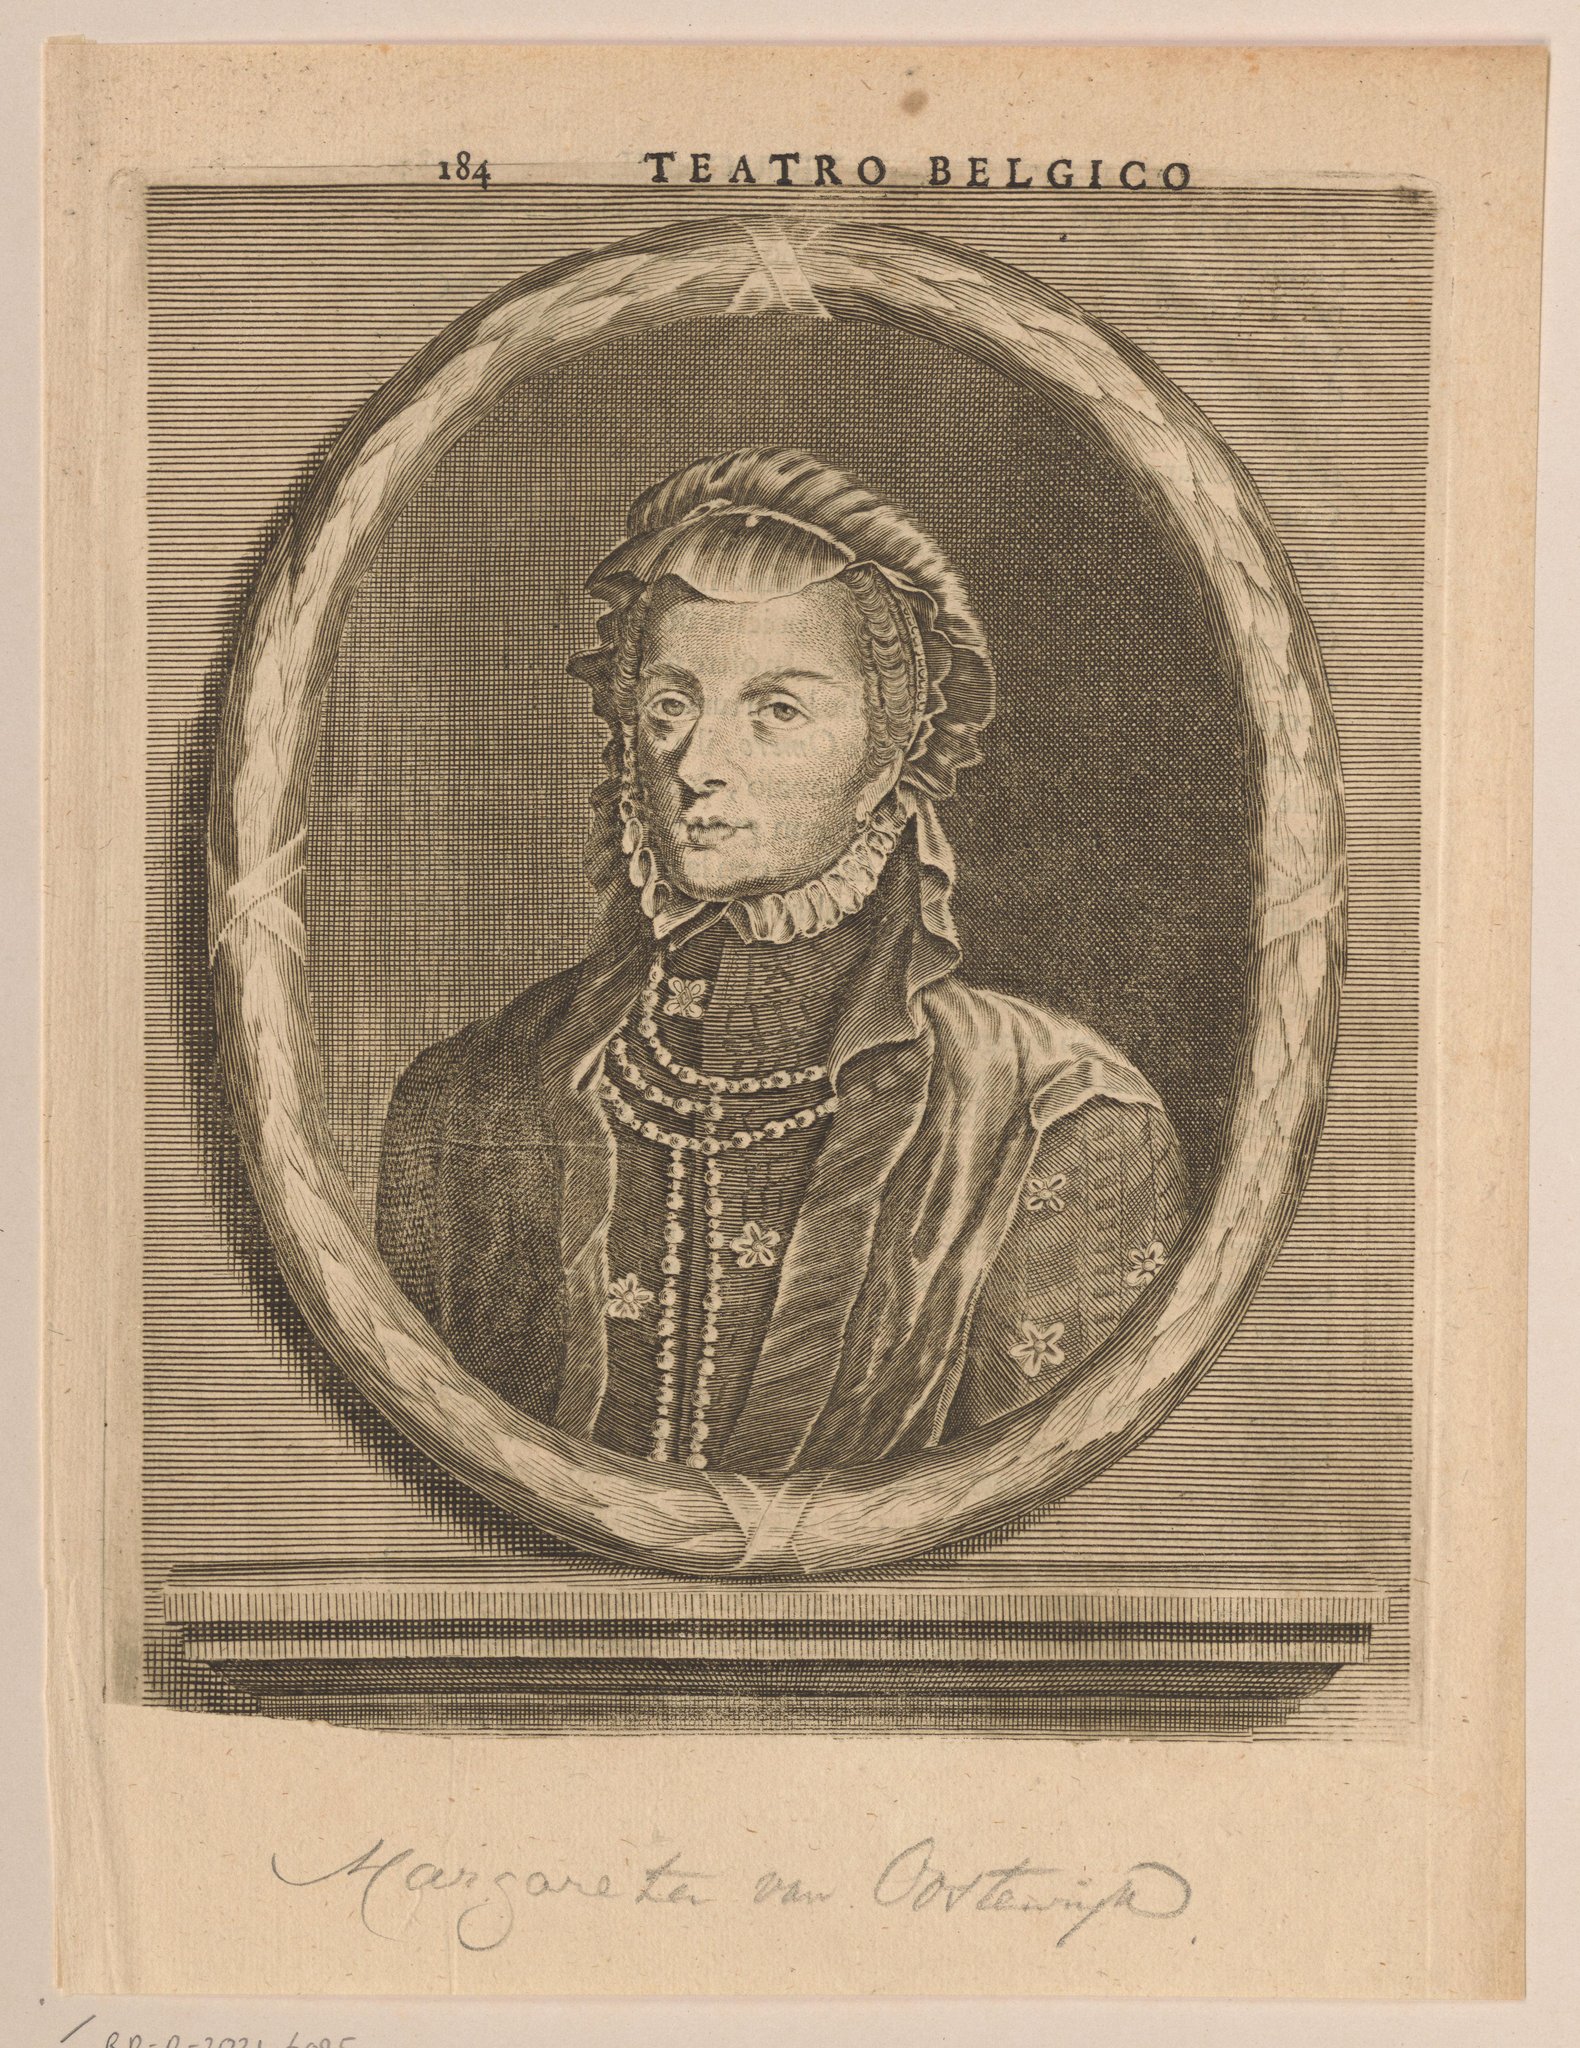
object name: print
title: Portret van Margaretha van Parma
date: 1690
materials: paper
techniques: engraving, letterpress printing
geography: northern netherlands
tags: historical persons - bb - woman, ornament ~ medallion, regent, substitute ruler; viceroy - bb - female ruler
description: Prent uit: Leti, Gregorio. Teatro Belgico, o verso ritratti historici, chronoligici, politici, e geografici (...). Amsterdam: Willem de Jonge, 1690, dl. 1, p. 184. Het onderste deel van de plaat is in deze uitgave afgedekt. De plaat is in zijn geheel in de eerste staat gebruikt in: Hooft, P.C. Nederlandsche Historien (...). Amsterdam: Johan van Someren et al., 1677. Een tweede bekende staat, met ander onderschrift, is gebruikt in: Bor, Pieter Christiaanszoon. Oorspronk, begin en vervolgh der Nederlandsche oorlogen (...). Amsterdam: weduwe Joannes van Someren et al., 1679, dl. 1. Een derde bekende staat, met 'Tom: I. No. 3', omlijst met een zwarte rand is gebruikt in 'Geschiedenissen der Vereenigde Nederlanden (...)', 1730.